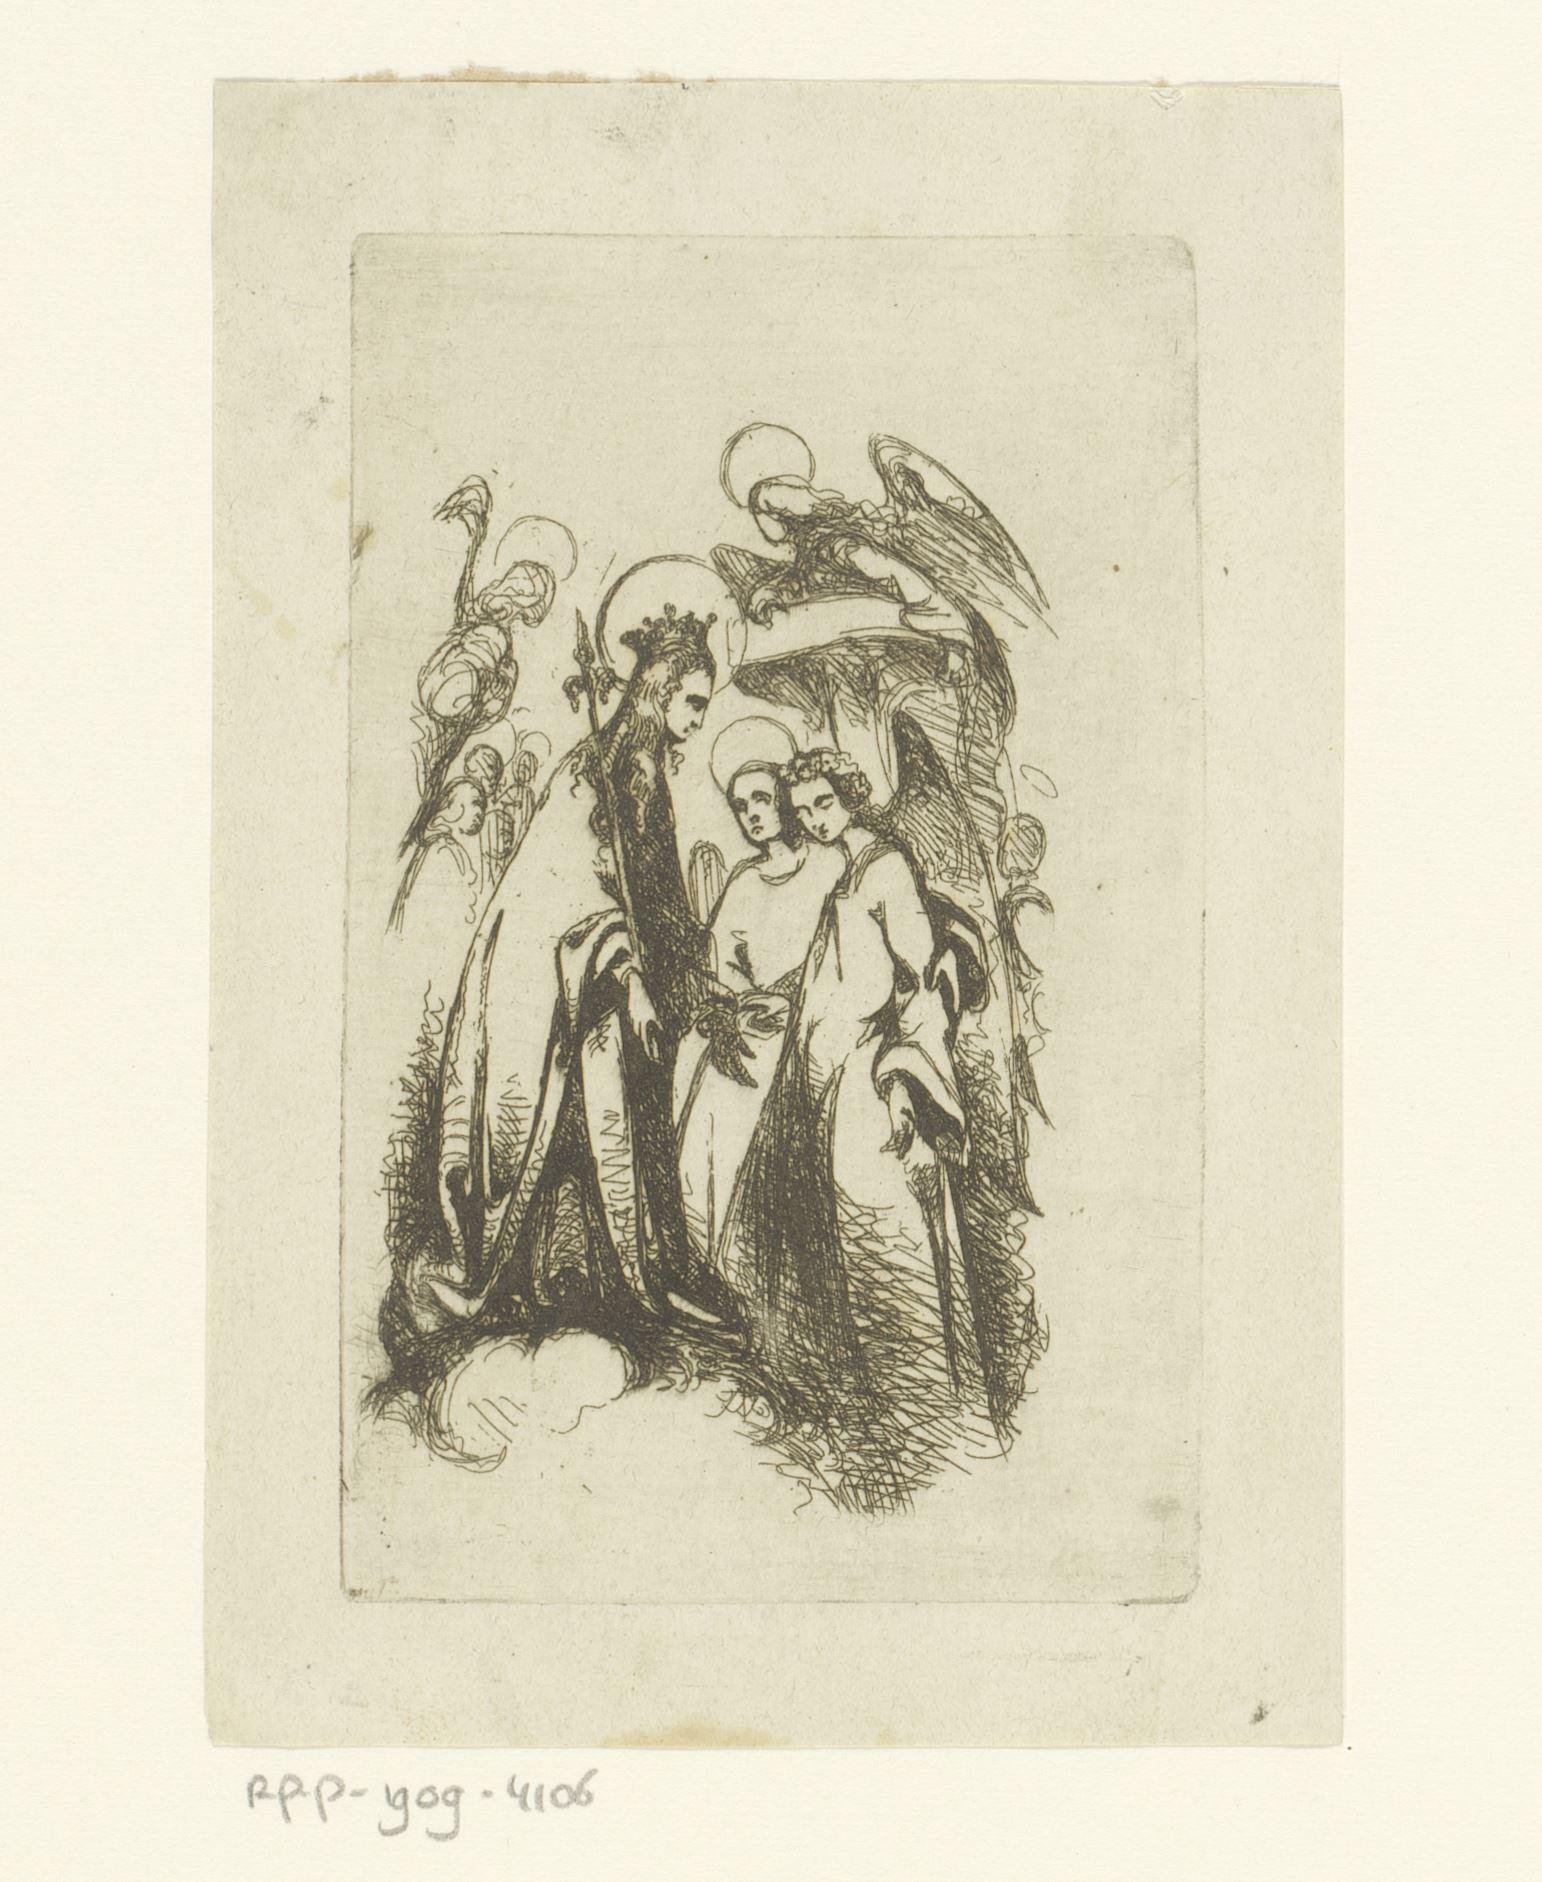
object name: print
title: Twee engelen leiden een vrouw voor Maria in de hemel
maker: franciscus andreas durlet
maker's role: draughtsman, print maker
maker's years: 1816-1867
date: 1844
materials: paper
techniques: etching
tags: (ascent into) heaven, the virgin mary, angels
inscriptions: collector's mark: Lugt 1485, collector's mark: Lugt 2228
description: Een prent van dezelfde prentmaker met eenzelfde voorstelling (zie RP-P-1909-4108) bevat op de achterzijde een overlijdensbericht van de zus van de prentmaker: Agnes Jeanne Durlet. Mogelijk stelt de vrouwenfiguur Agnes Jeanne voor die na haar overlijden in 1844 voor Maria in de hemel zou verschijnen.